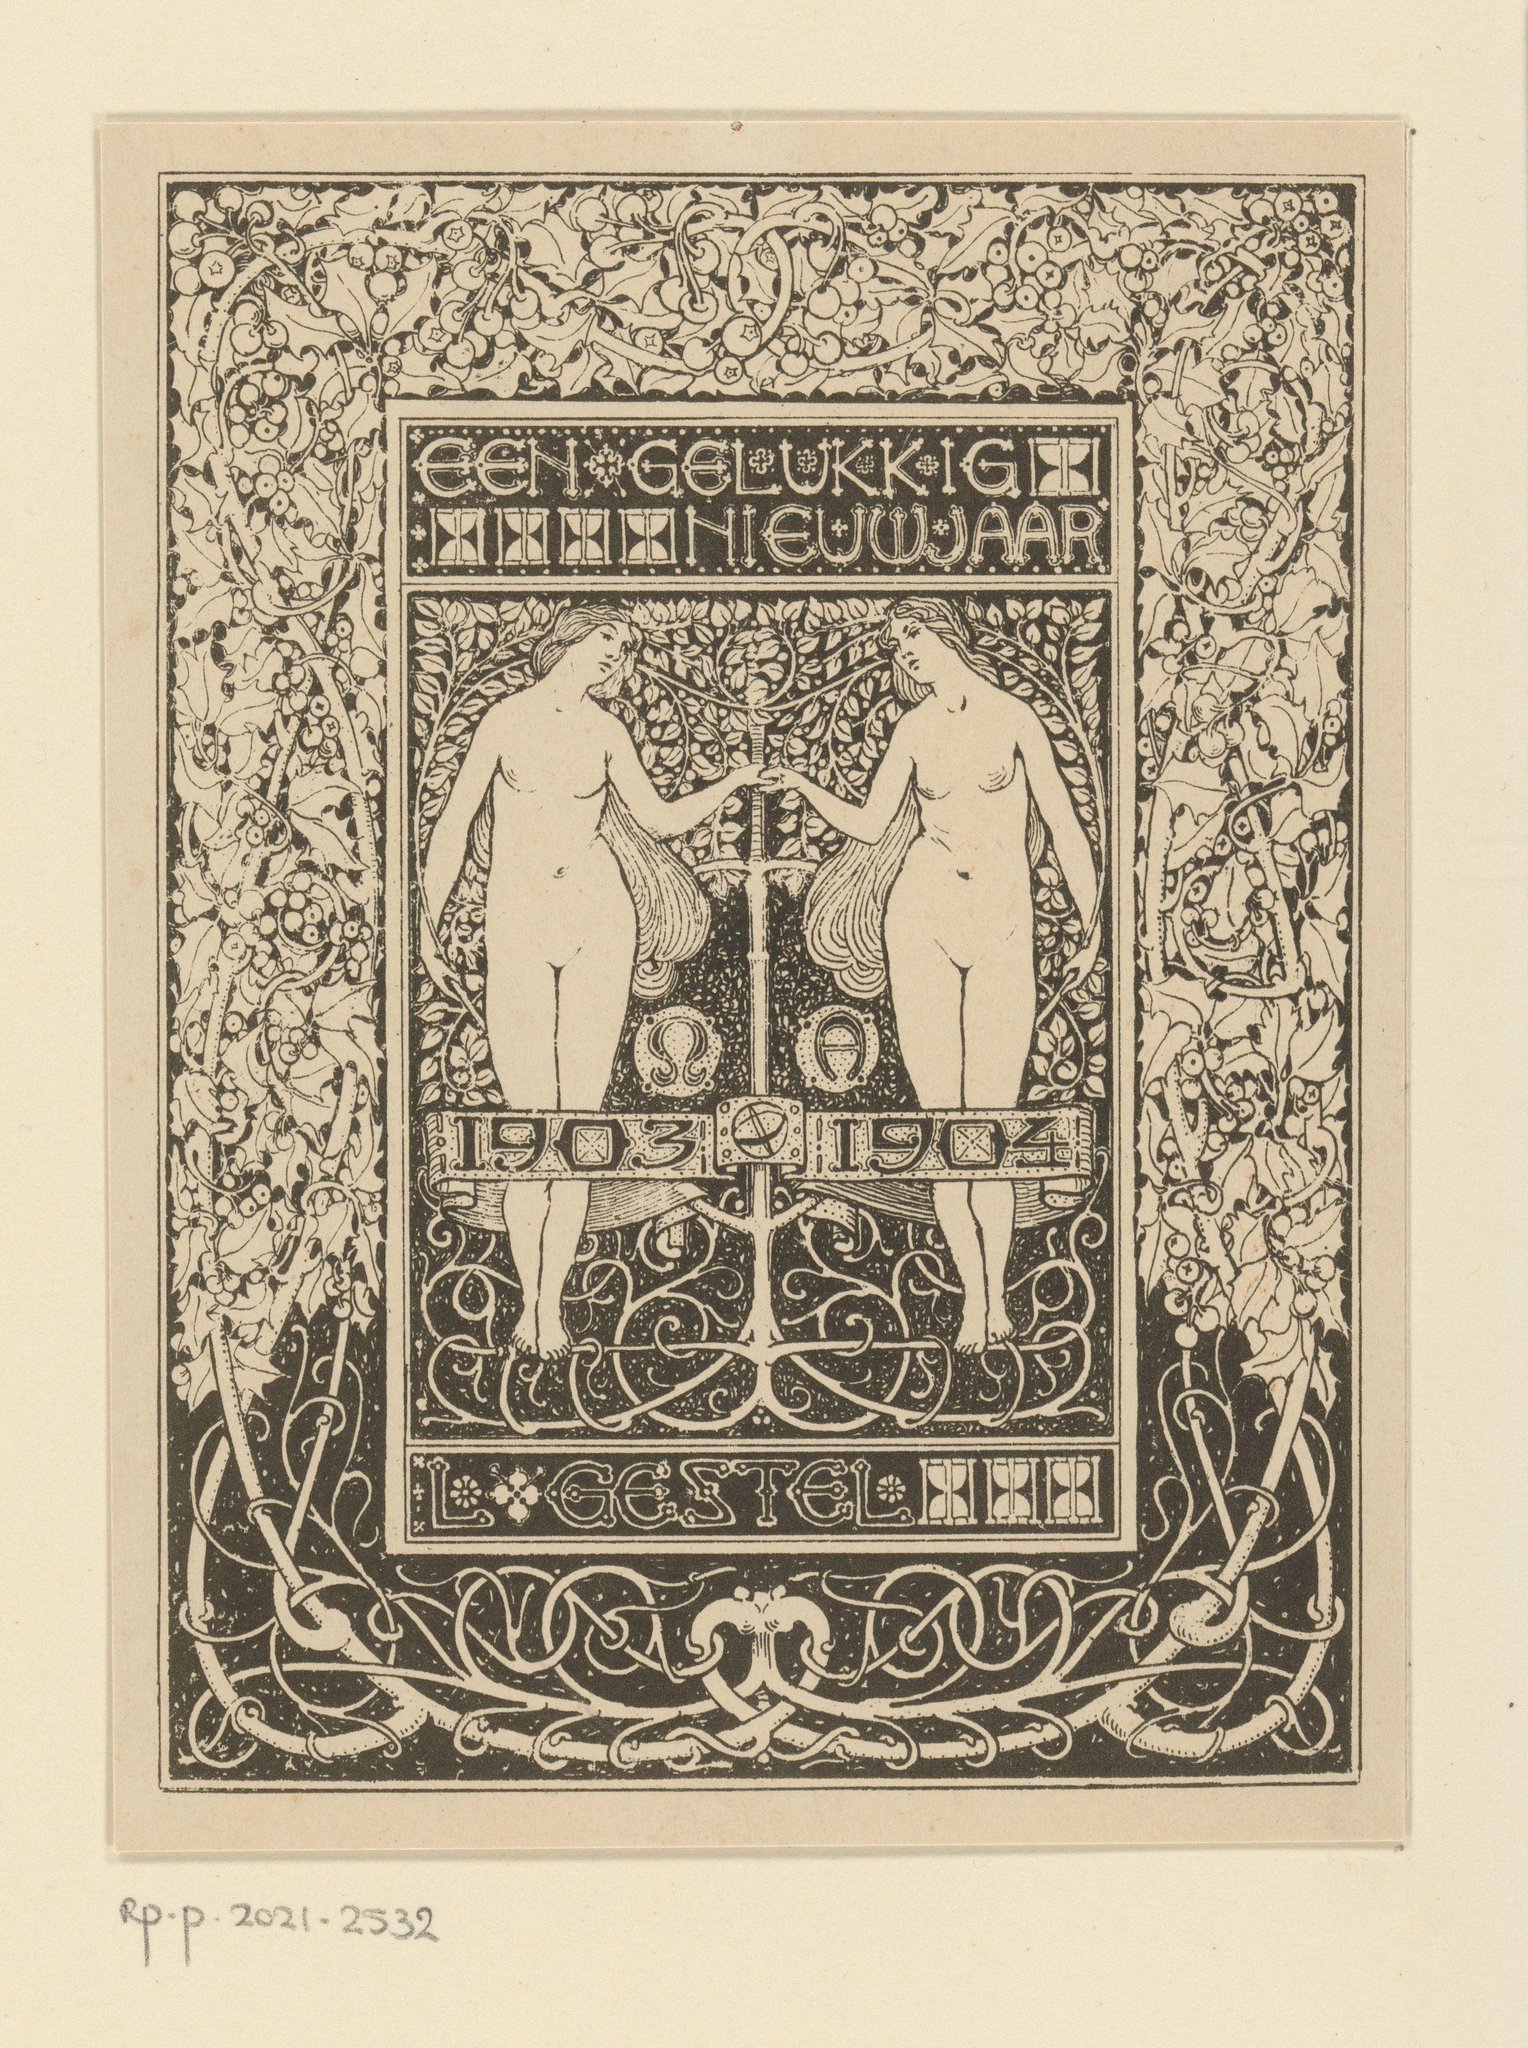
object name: print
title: Nieuwjaarswens voor 1904 van Leo Gestel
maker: leo gestel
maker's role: draughtsman, print maker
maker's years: 1881-1941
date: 1889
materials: paper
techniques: lithograph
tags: print maker, draughtsman, leo gestel, vine, woman (showing herself) undressed, quasi-nude, hacking and thrusting weapons: sword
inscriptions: date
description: Twee naakte vrouwenfiguren aan weerszijden van een zwaard. Ter hoogte van de knieën van de vrouwen links Ω 1903 en rechts α 1904. Daaromheen een decoratieve rand van wijnranken in de stijl van de Arts-and-craftsbeweging.